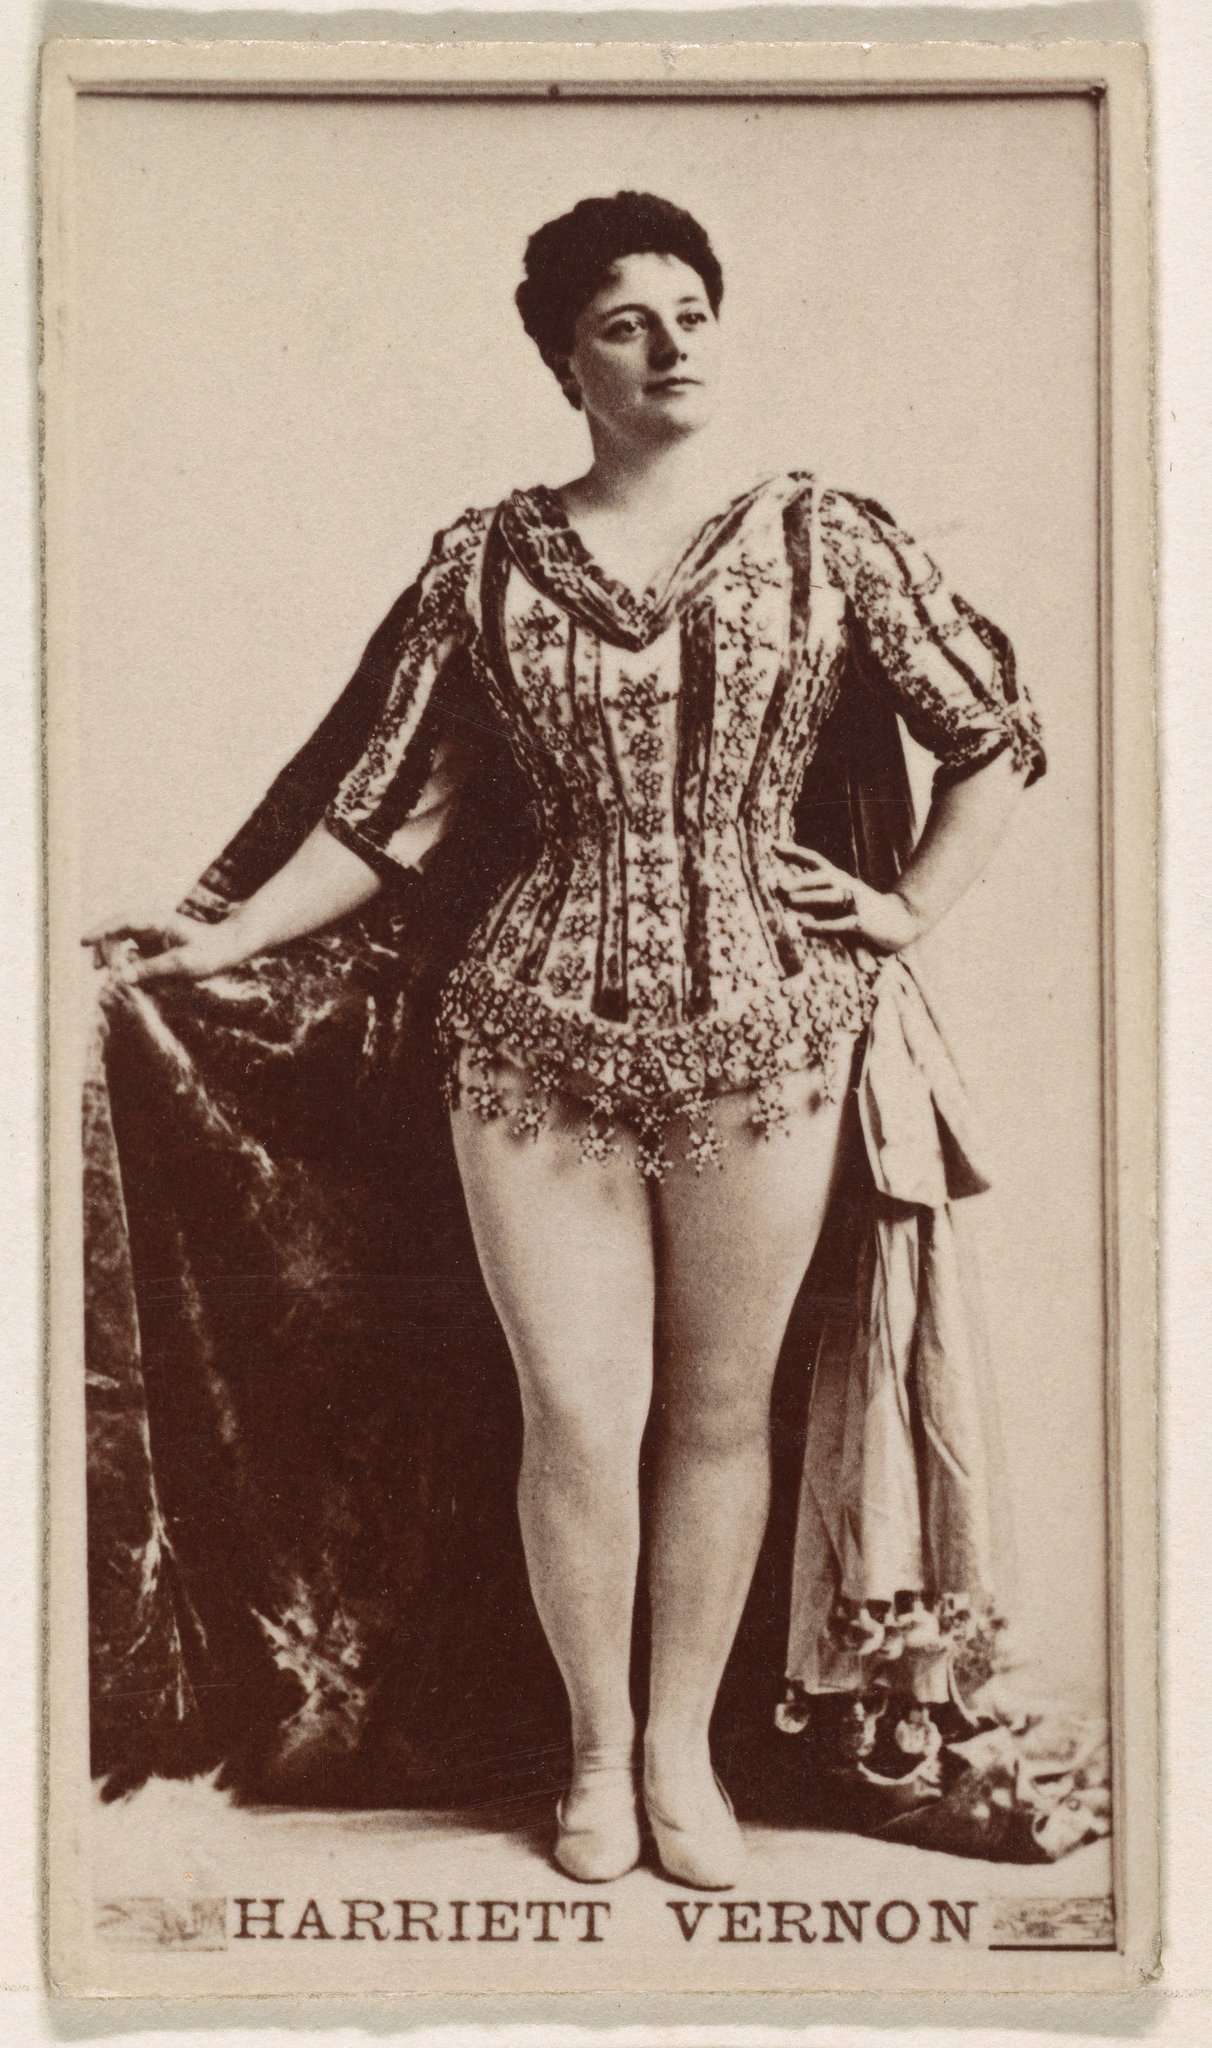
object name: photograph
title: Harriett Vernon, from the Actresses series (N245) issued by Kinney Brothers to promote Sweet Caporal Cigarettes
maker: kinney brothers tobacco company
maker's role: publisher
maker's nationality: american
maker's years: 1869-2011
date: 1890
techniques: albumen silver print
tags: portraits,women,actresses